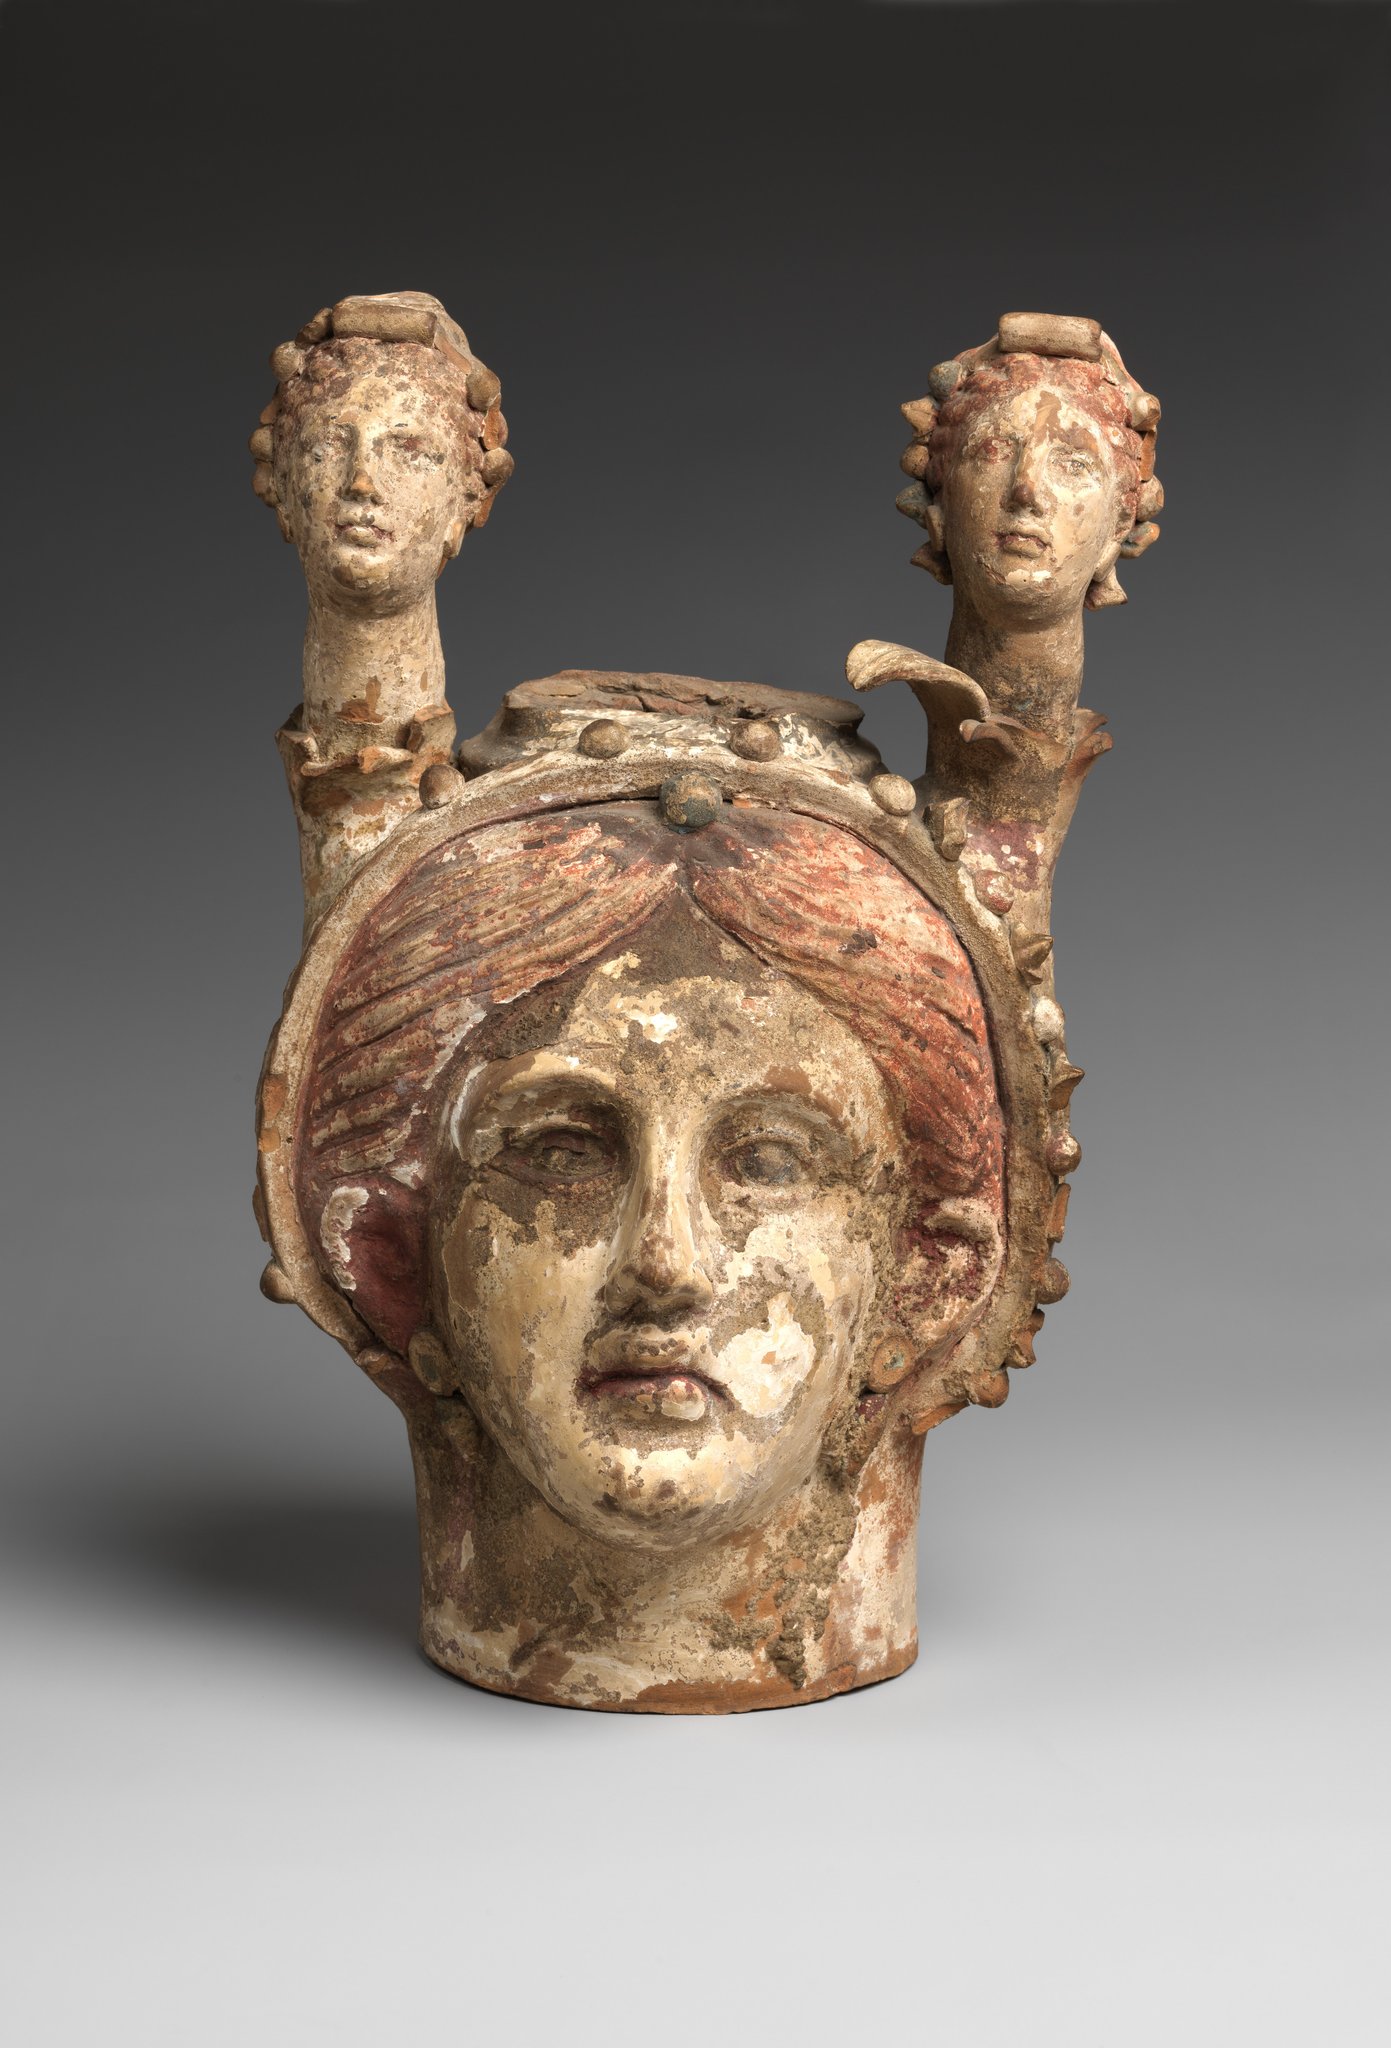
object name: vase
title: Polychrome terracotta head vase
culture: canosan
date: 300-101 BCE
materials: terracotta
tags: heads